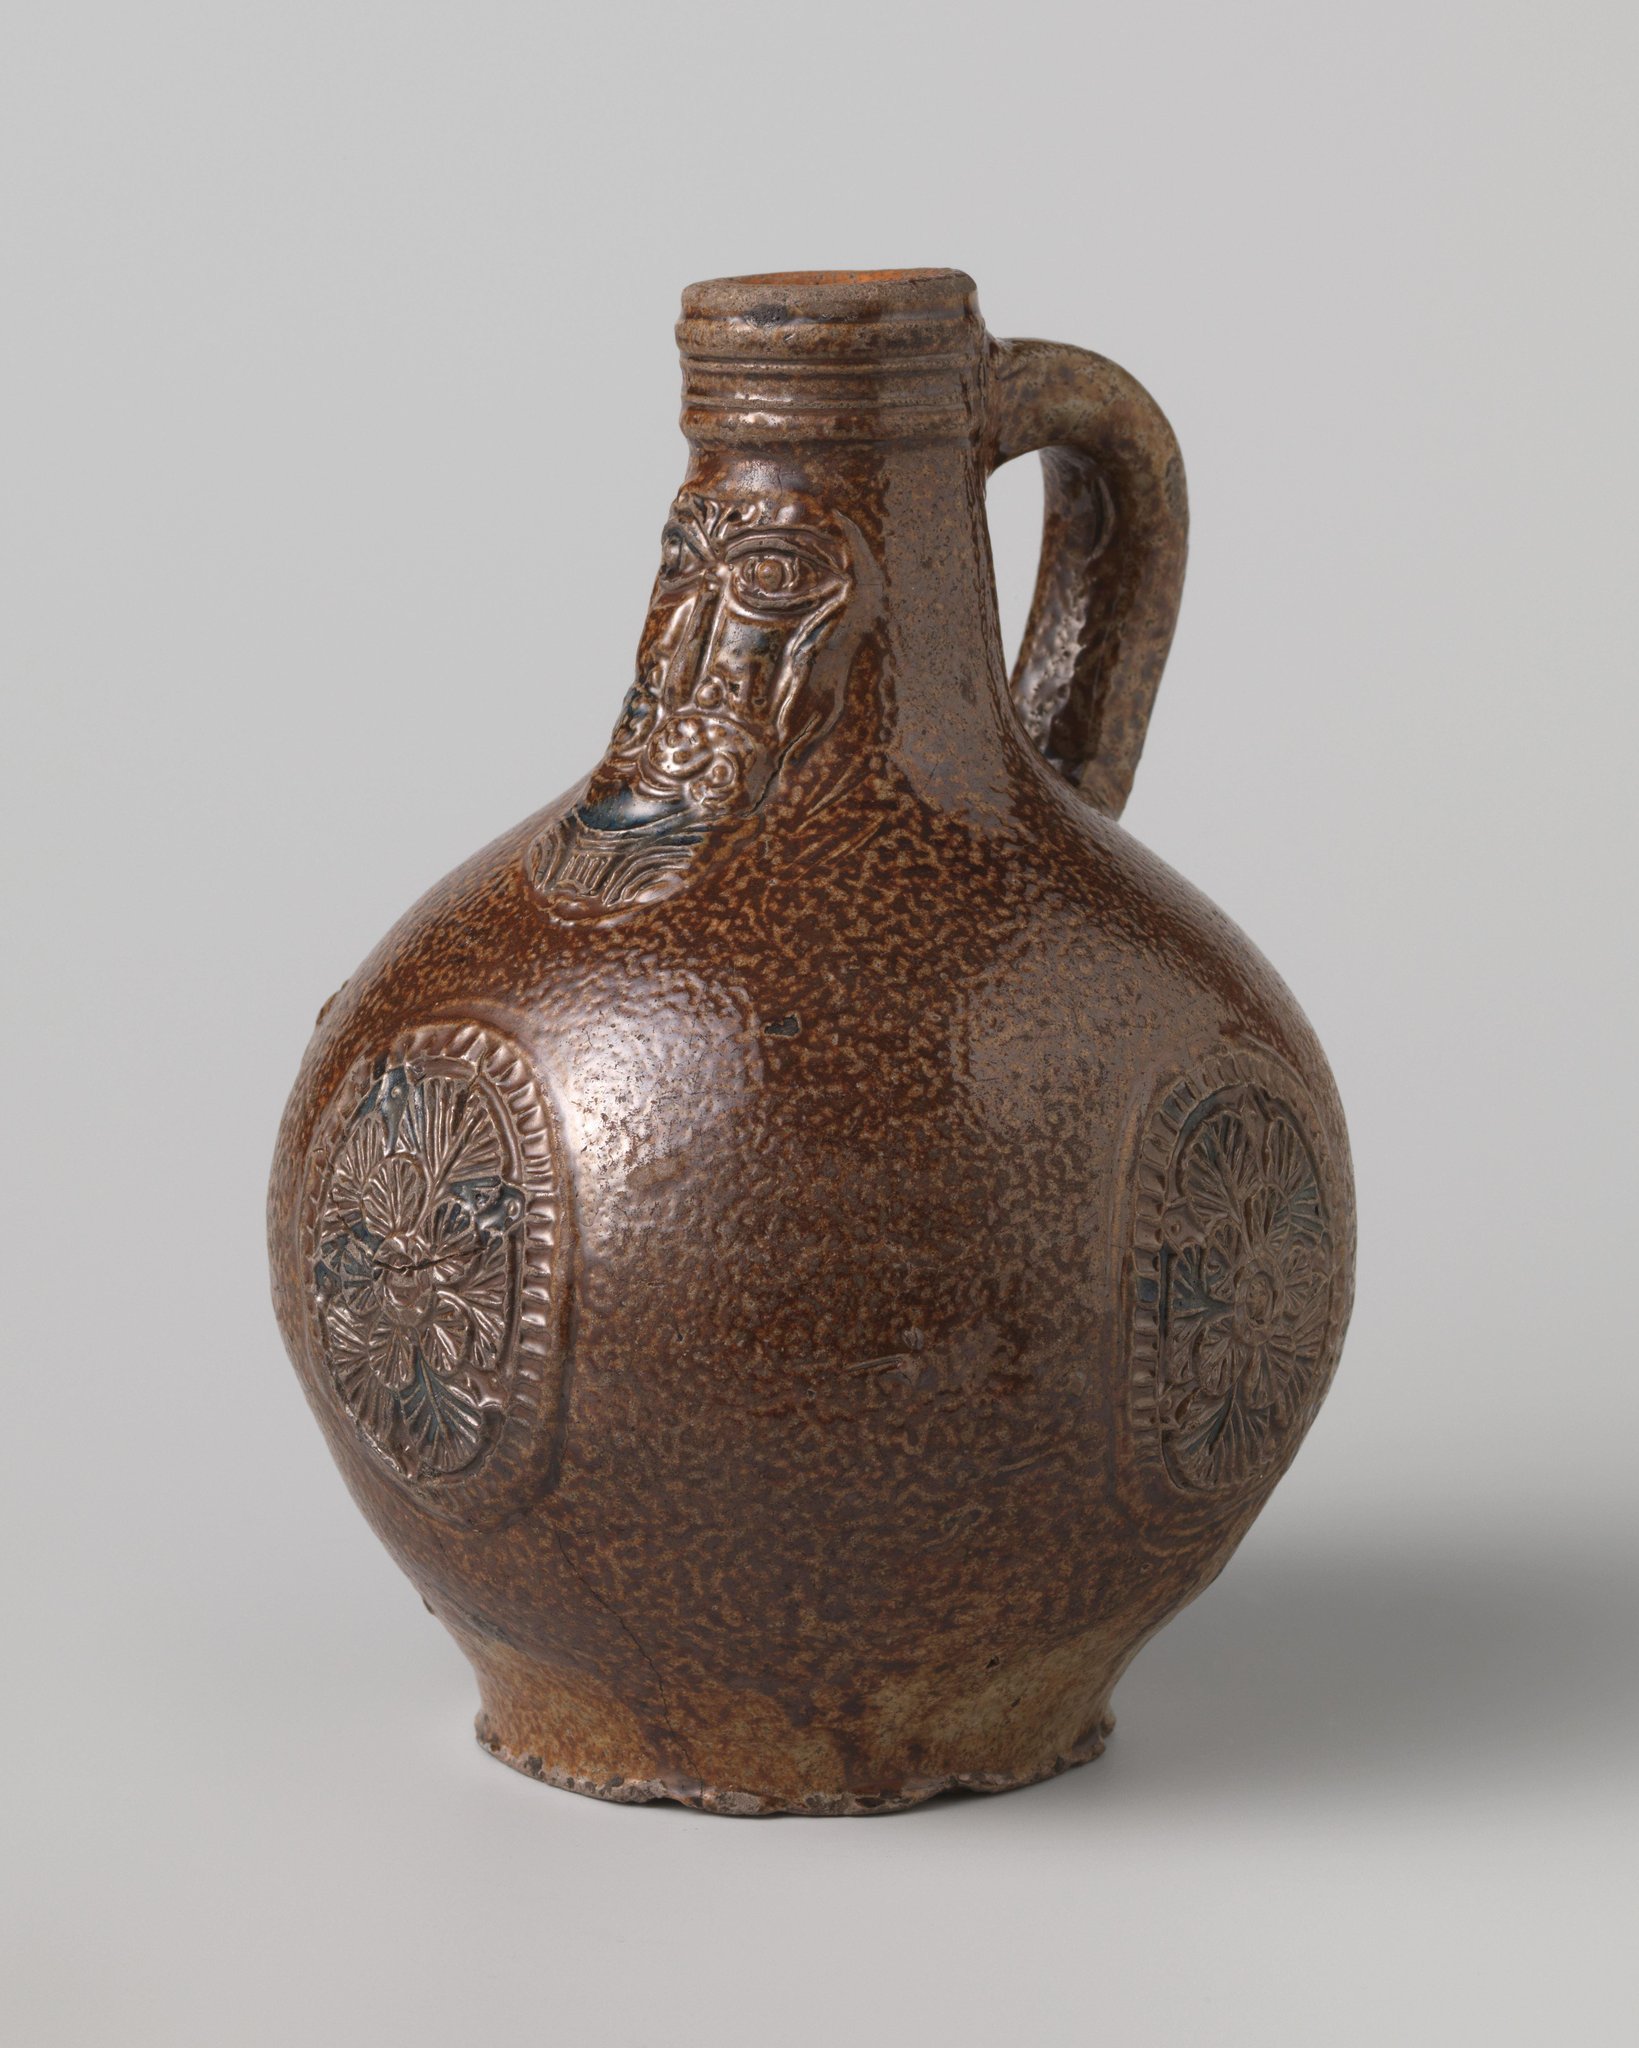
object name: bellarmine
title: Jug (Bartmann jug) with a flower in a medallion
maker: Anonymous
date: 1600-1750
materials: engobe, glaze, stoneware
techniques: firing, forming, relief, turning, vitrification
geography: frechen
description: Kruik (baardmankruik) van steengoed op standvlak met een bolvormig lichaam en smalle nek. Het C-vormige oor is bevestigd aan de nek en de schouder. Profielen op de nek. Bedekt met een bruine engobe en kobaltblauw. Op de buik in reliëf driemaal een gedrukt en opgelegd medaillon met een bloem. Op de nek, doorlopend op de schouder, een baardman. Frechen.